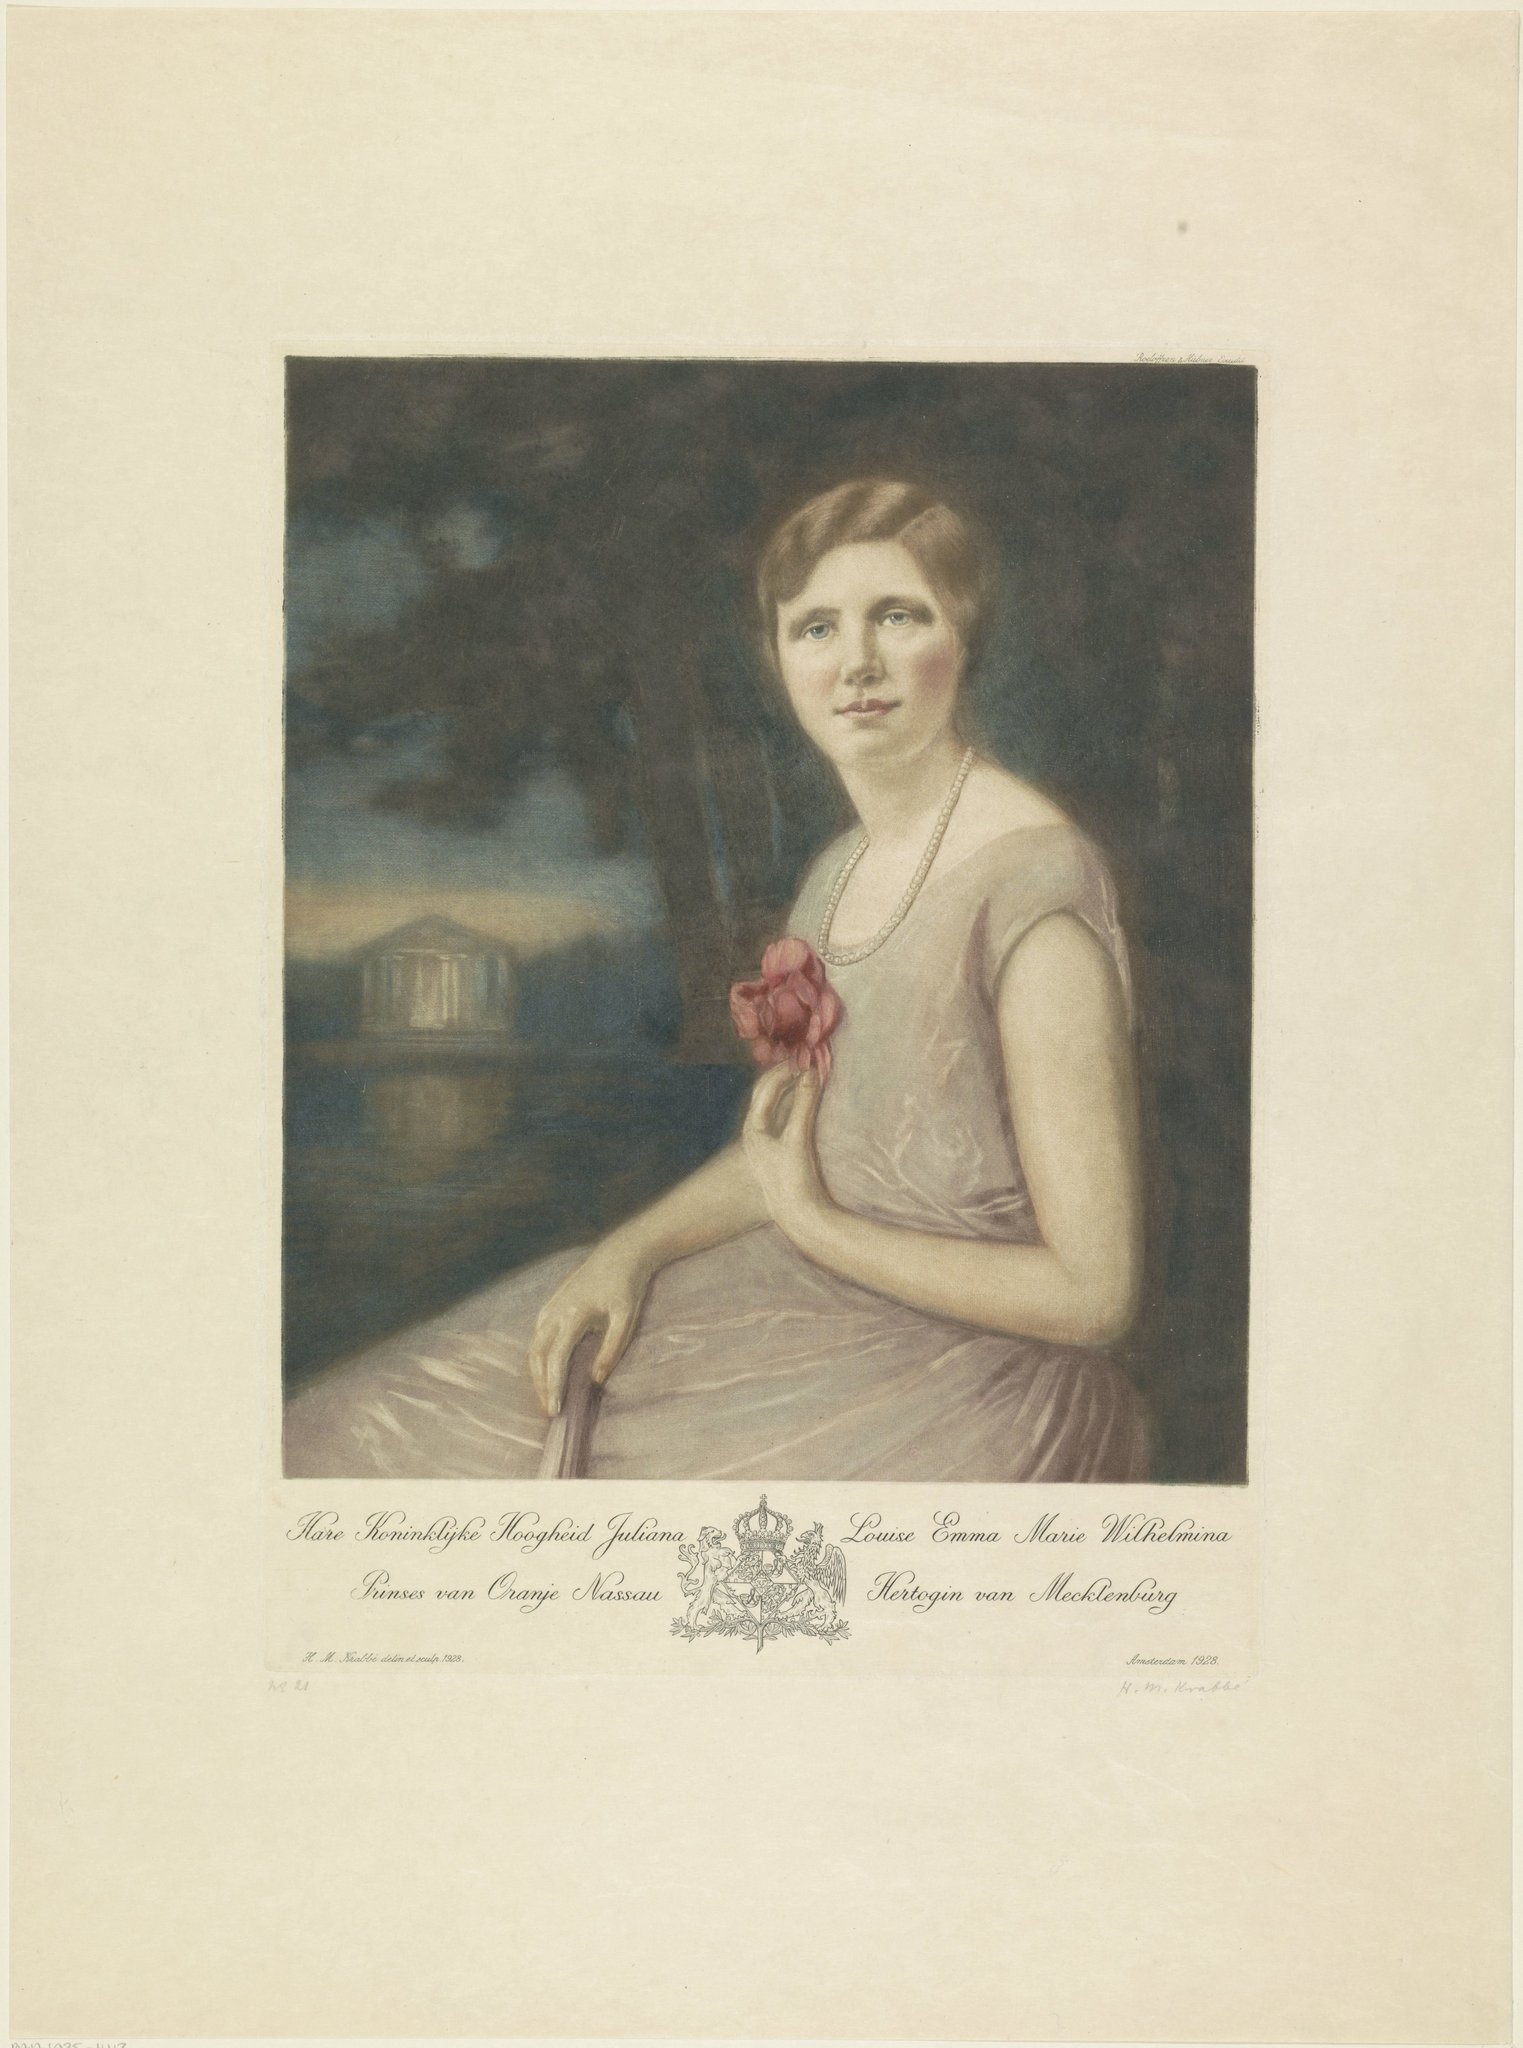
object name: print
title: Portret van Juliana, koningin der Nederlanden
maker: heinrich m. krabbé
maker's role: draughtsman, print maker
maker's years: 1868-1931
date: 1928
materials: paper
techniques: mezzotint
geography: amsterdam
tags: the hague, juliana of the netherlands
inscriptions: collector's mark: Lugt 2760, collector's mark: Lugt 2166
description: Portret van Juliana. In haar rechterhand een waaier. In haar linkerhand een bloem. Op de achtergrond een tempel. Midden onder een wapen. In de ondermarge haar naam en titels.